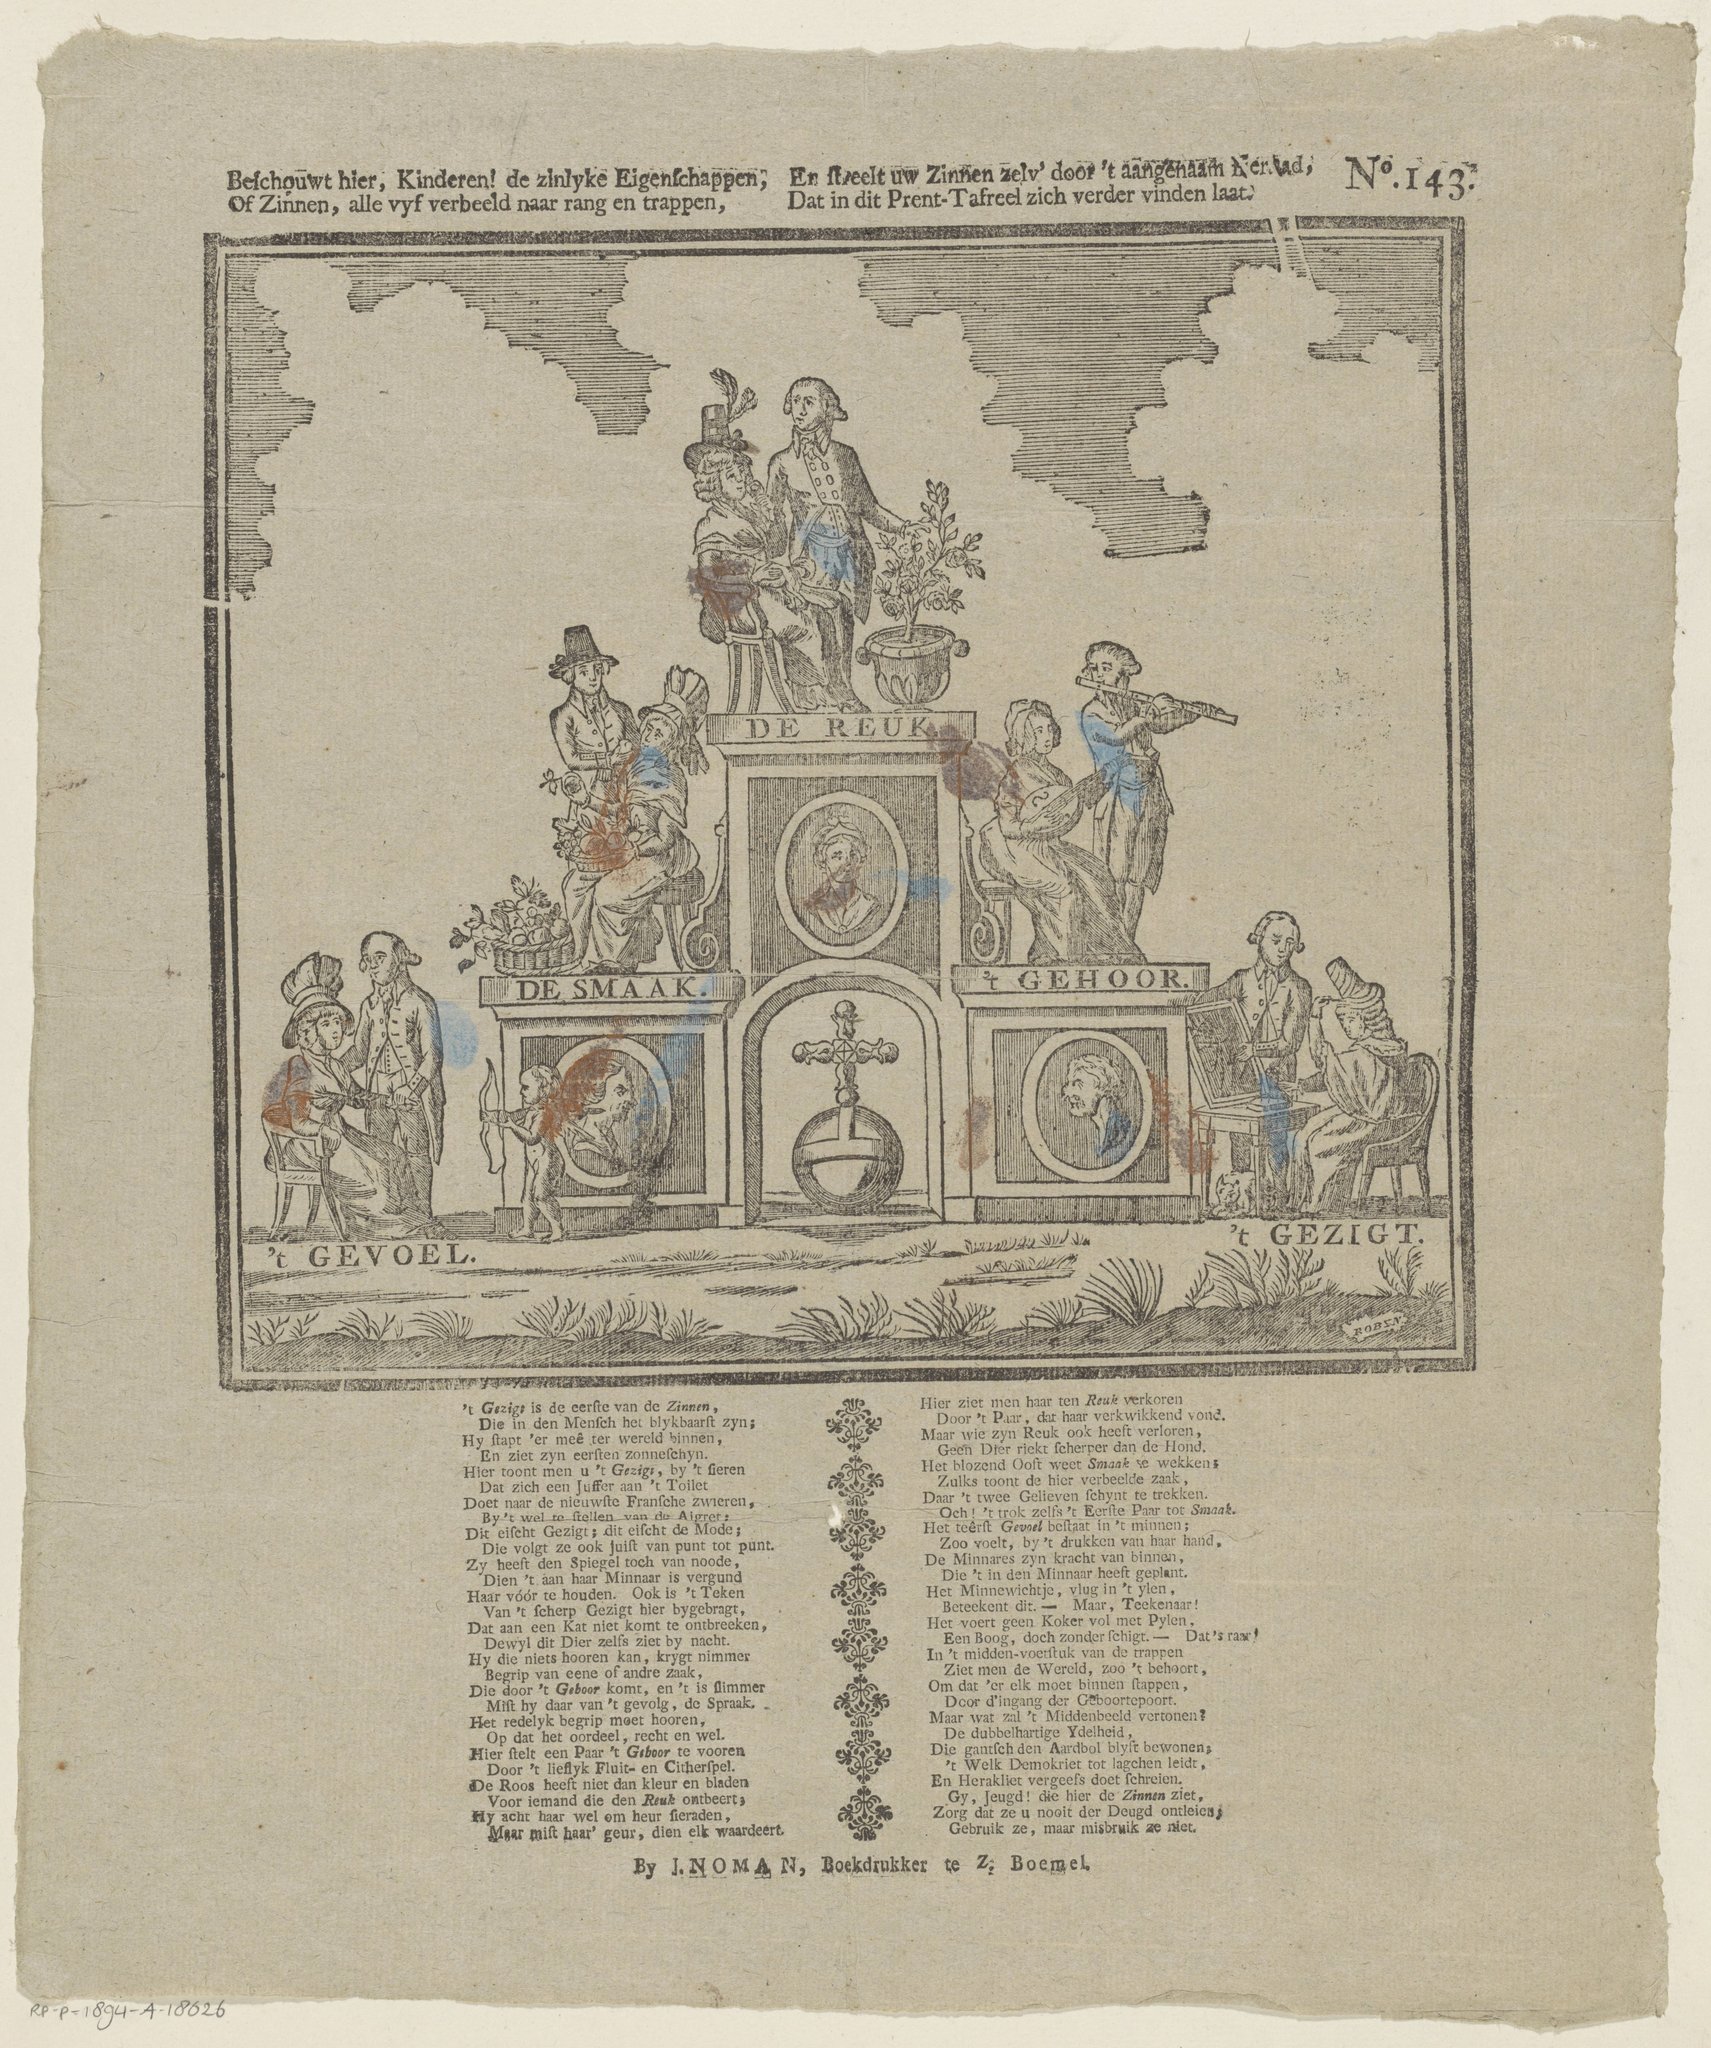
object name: popular print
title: Beschouwt hier, kinderen! de zinlyke eigenschappen, / of zinnen, alle vyf verbeeld naar rang en trappen, / En streelt uw zinnen zelv' door 't aangenaam sieraad, / Dat in dit prent-tafreel zich verder vinden laat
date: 1806-1830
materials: paper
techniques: colour, letterpress printing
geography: netherlands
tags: the (five) senses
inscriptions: collector's mark: Lugt 2760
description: Trap met op elke trede een paar dat één van de vijf zintuigen verbeeld. Van links naar rechts: het gevoel, de smaak, de reuk, het gehoor en het gezicht. Op de trap ook drie medaillons met portretten. Onder de afbeelding een vers in twee kolommen. Genummerd rechtsboven: No. 143.